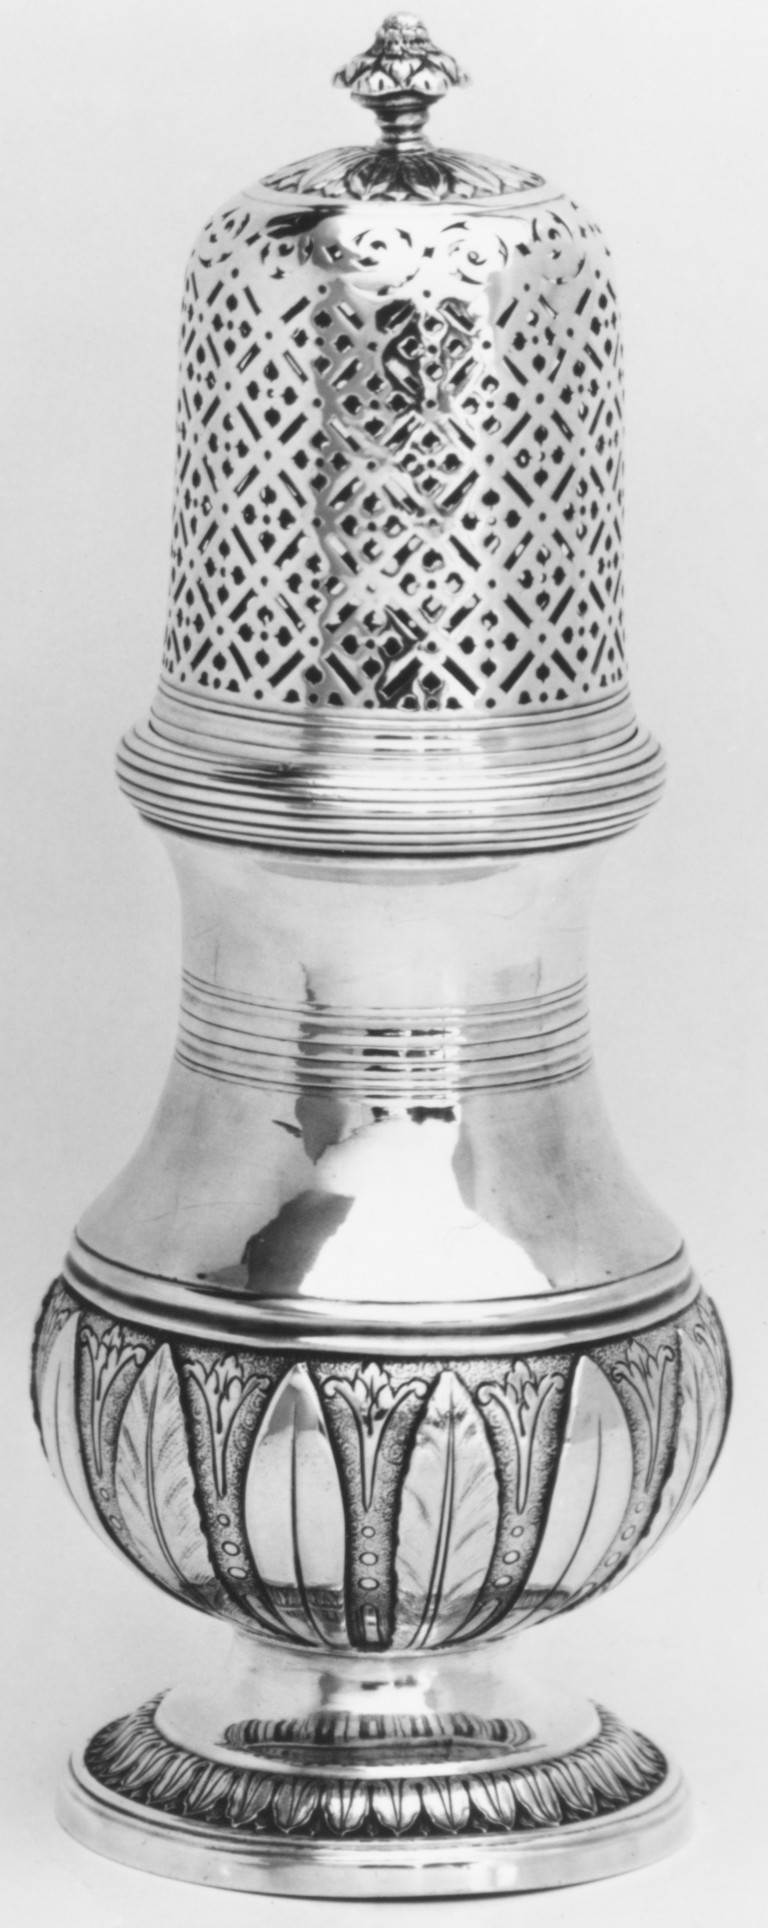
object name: sugar caster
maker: pierre belleville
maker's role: maker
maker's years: 1700-1765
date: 1739-1740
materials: silver